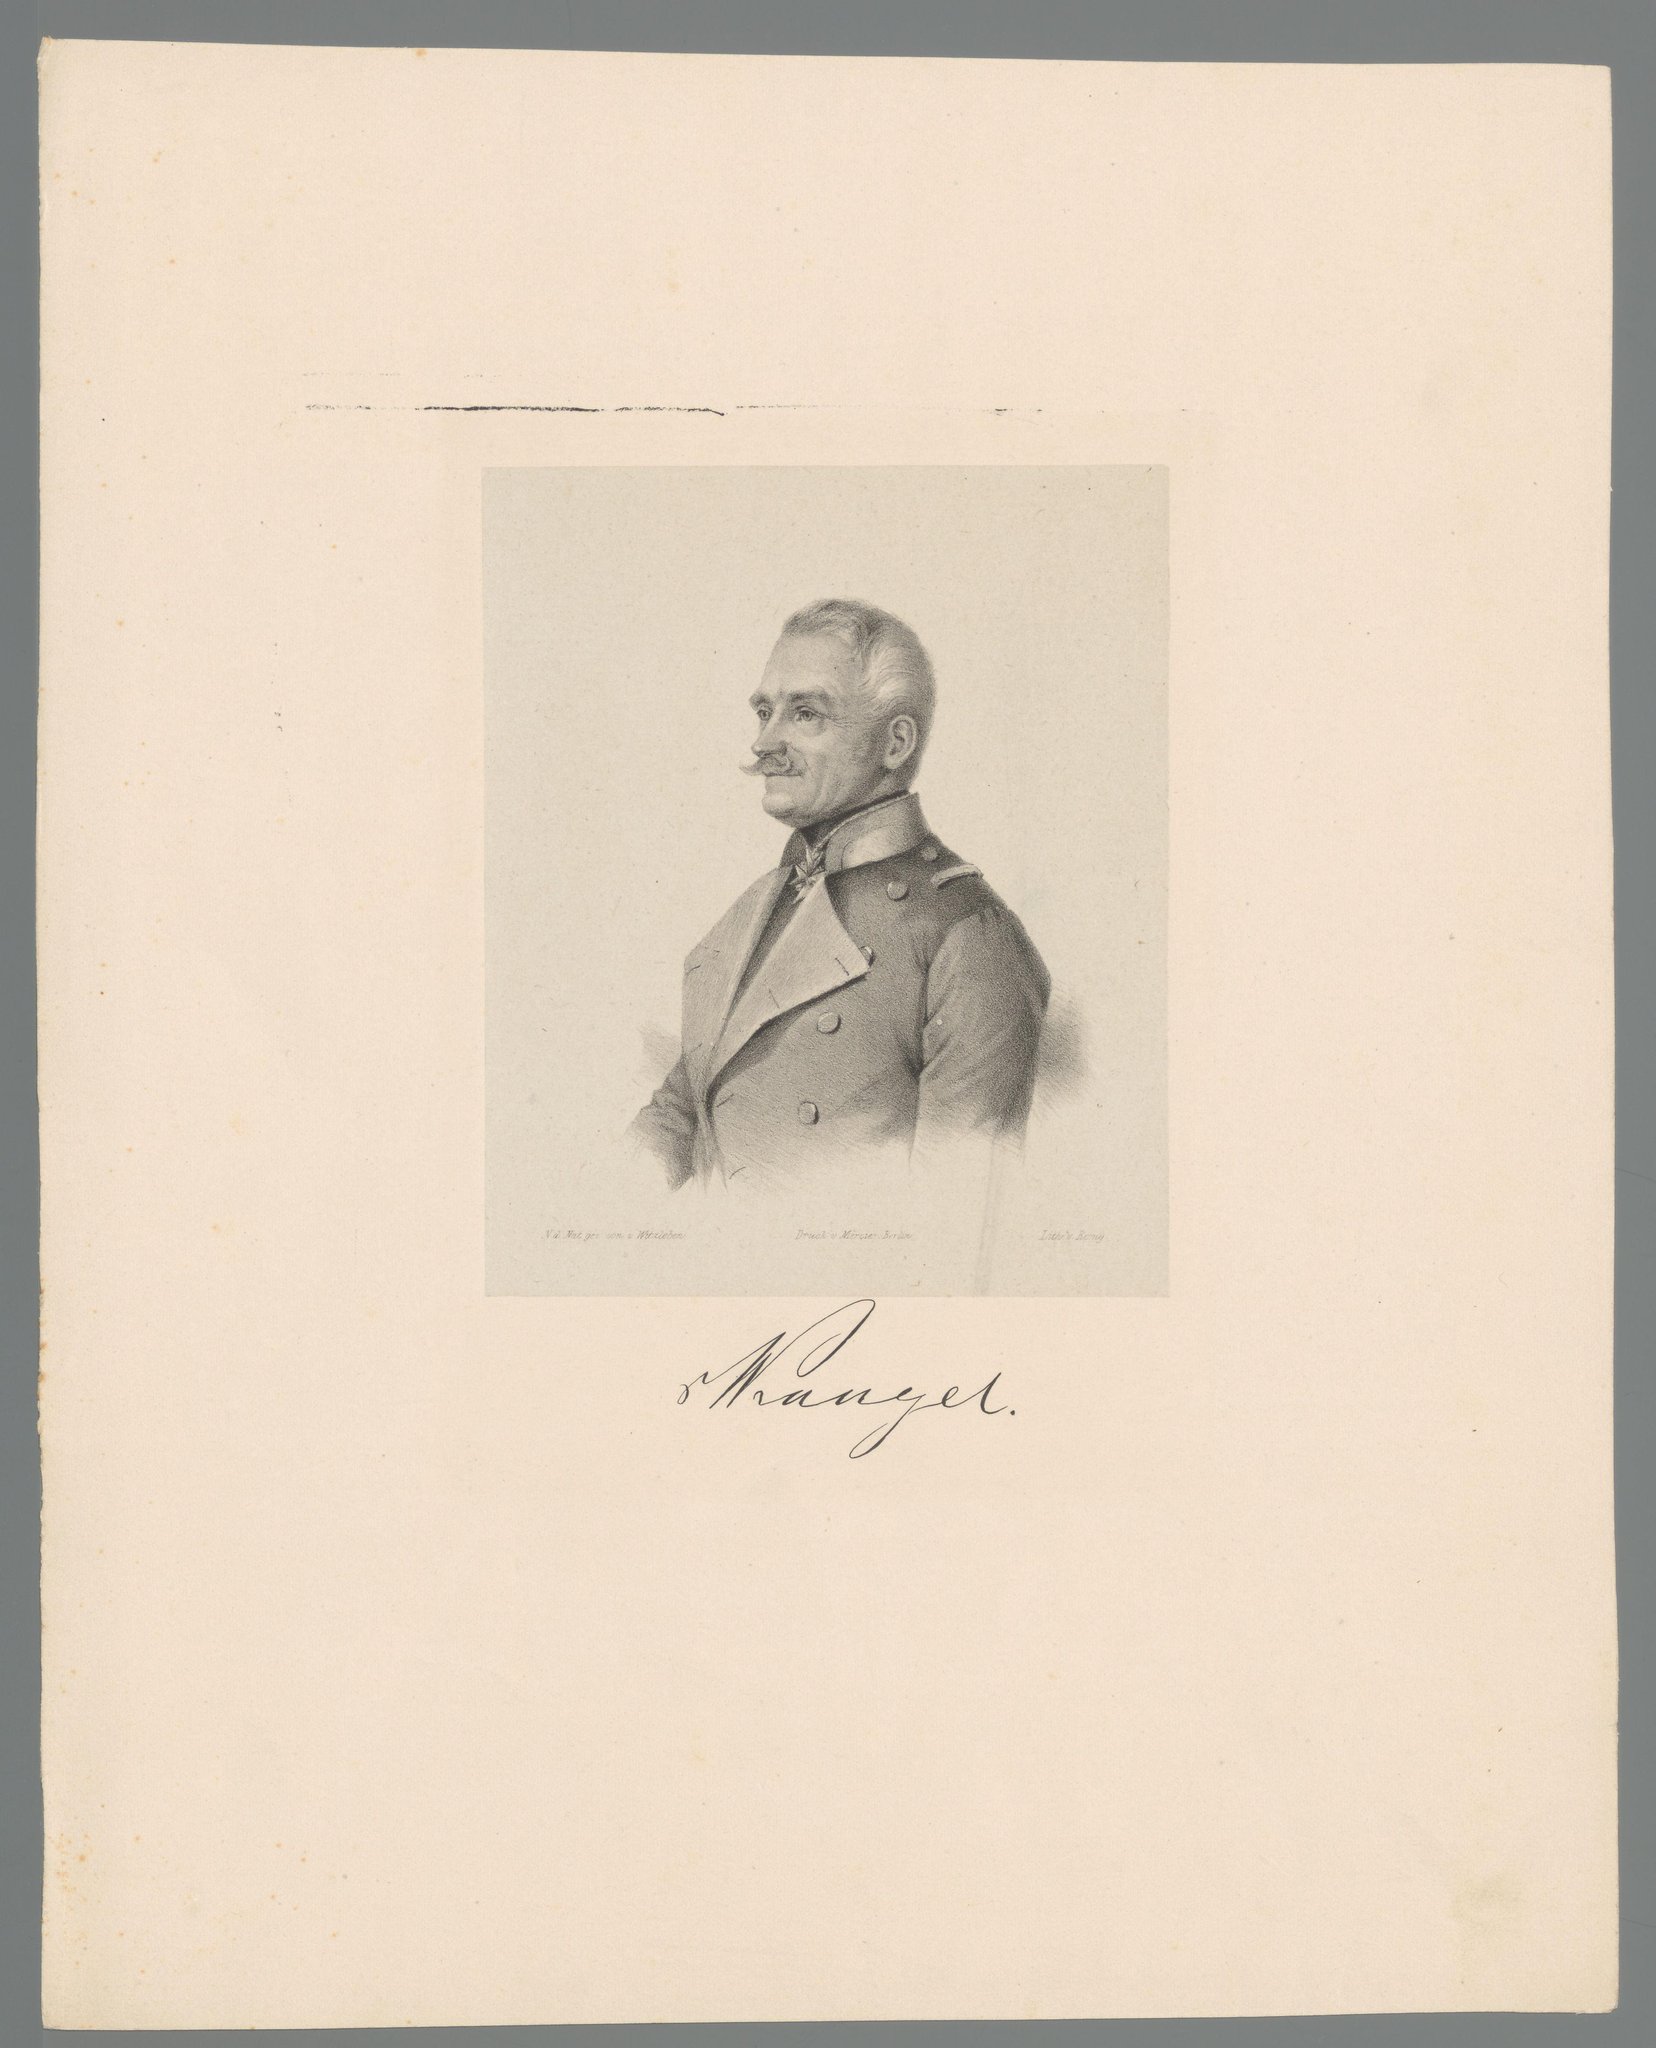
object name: print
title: Portret van Friedrich von Wrangel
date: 1810-1872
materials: paper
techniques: lithograph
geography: berlin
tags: berlin, moustache, adult man, historical persons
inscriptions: collector's mark: Lugt 2228